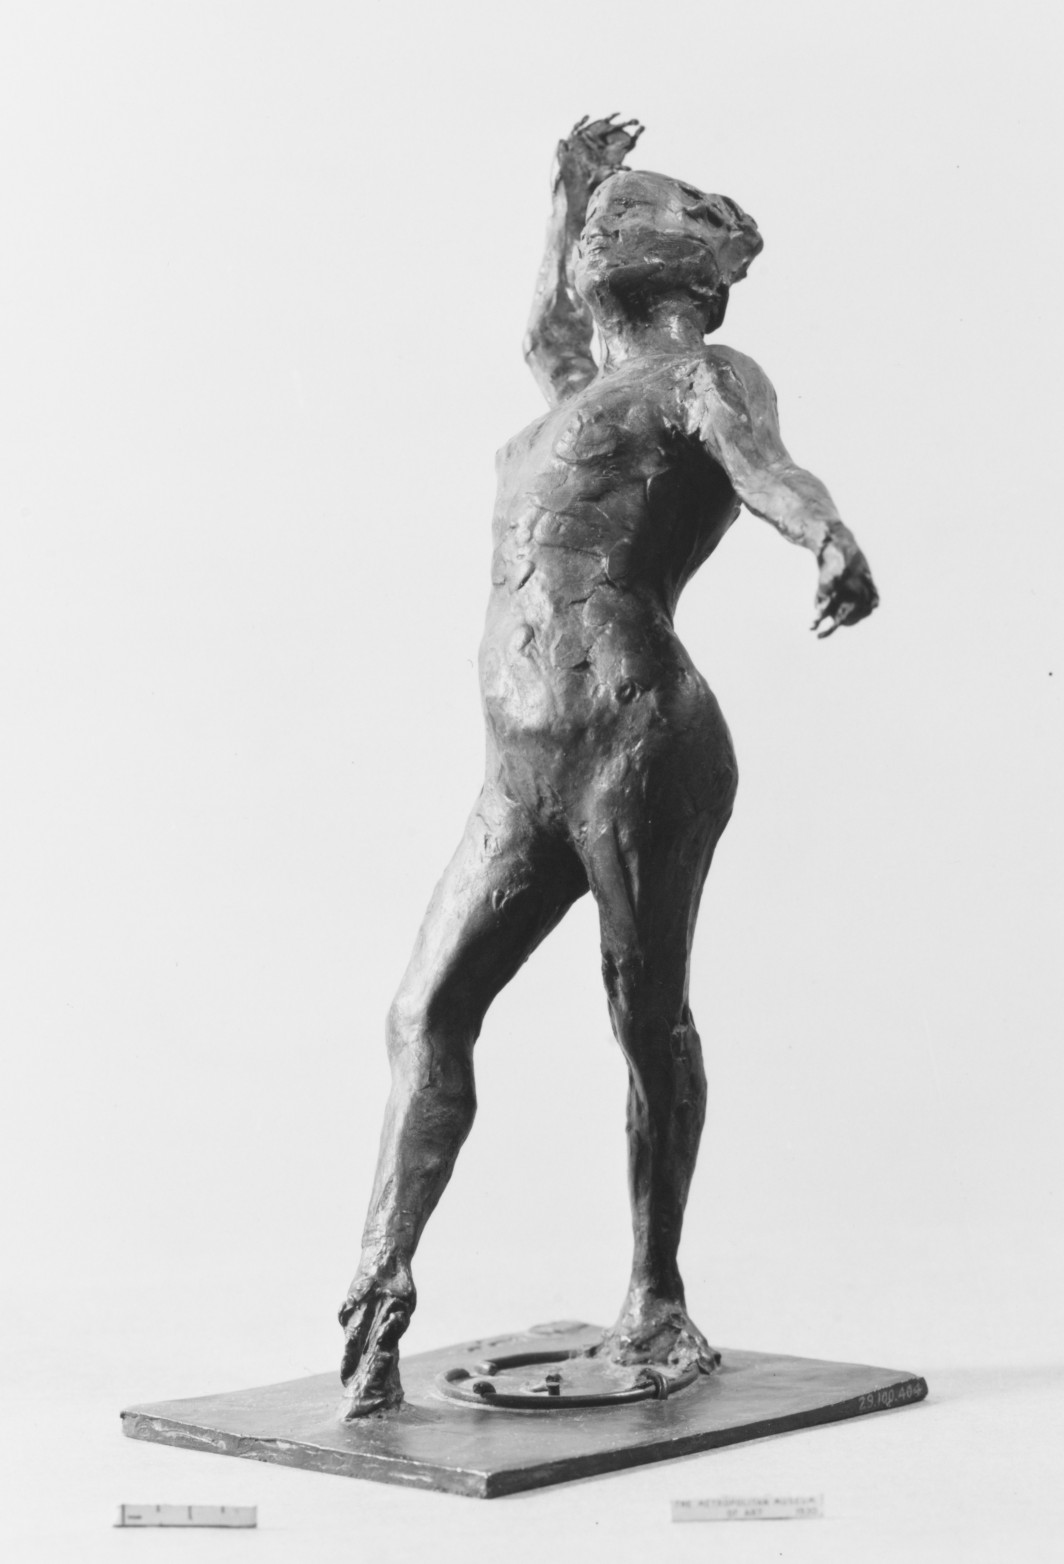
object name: statuette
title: Dancer with Tambourine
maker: edgar degas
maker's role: artist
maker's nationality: french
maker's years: 1834-1917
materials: bronze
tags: women,dancing,dancers